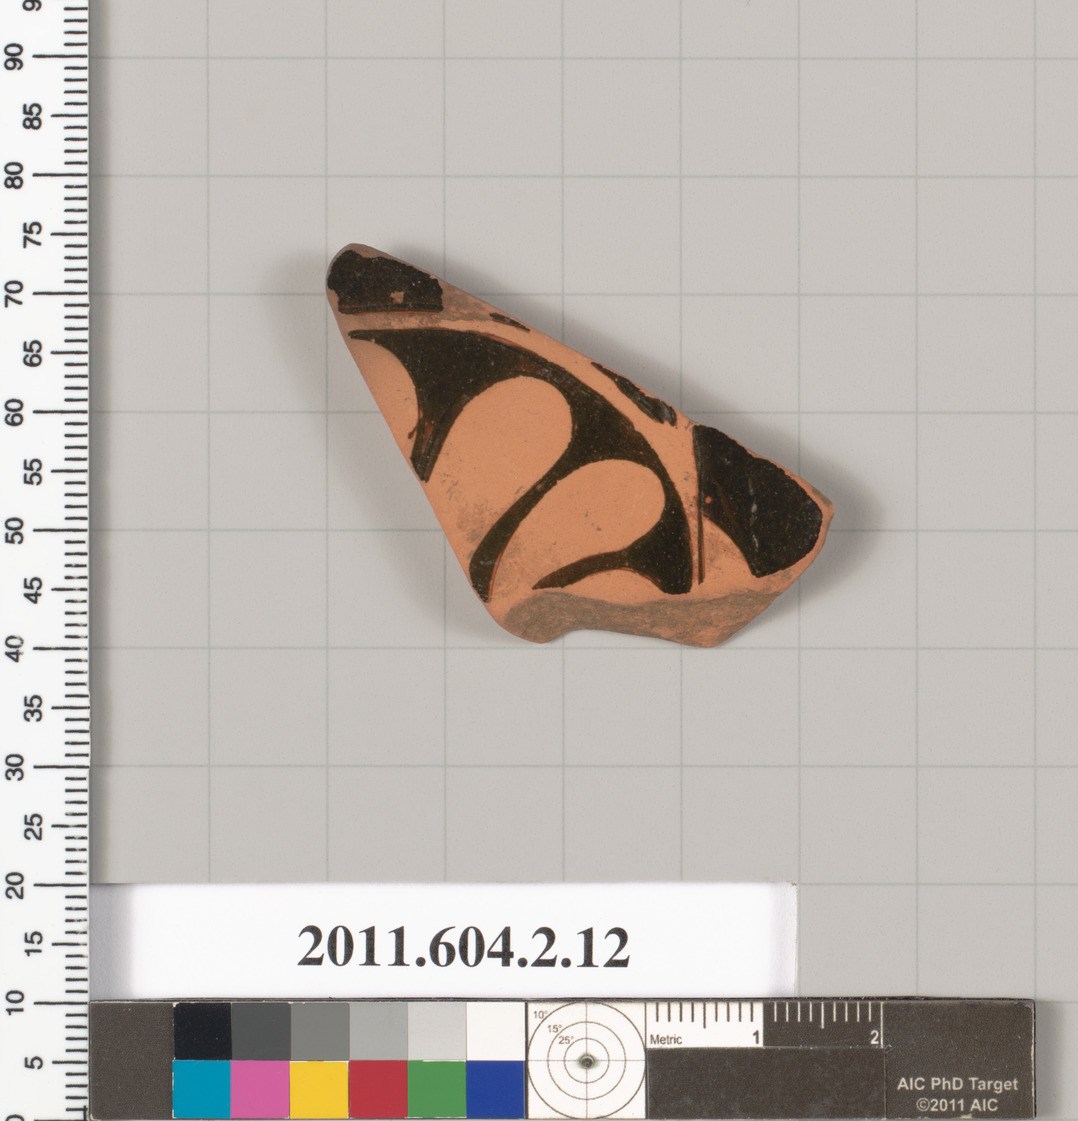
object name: neck amphora fragment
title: Terracotta fragment of a neck-amphora (jar)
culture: greek, attic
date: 500-480 BCE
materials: terracotta